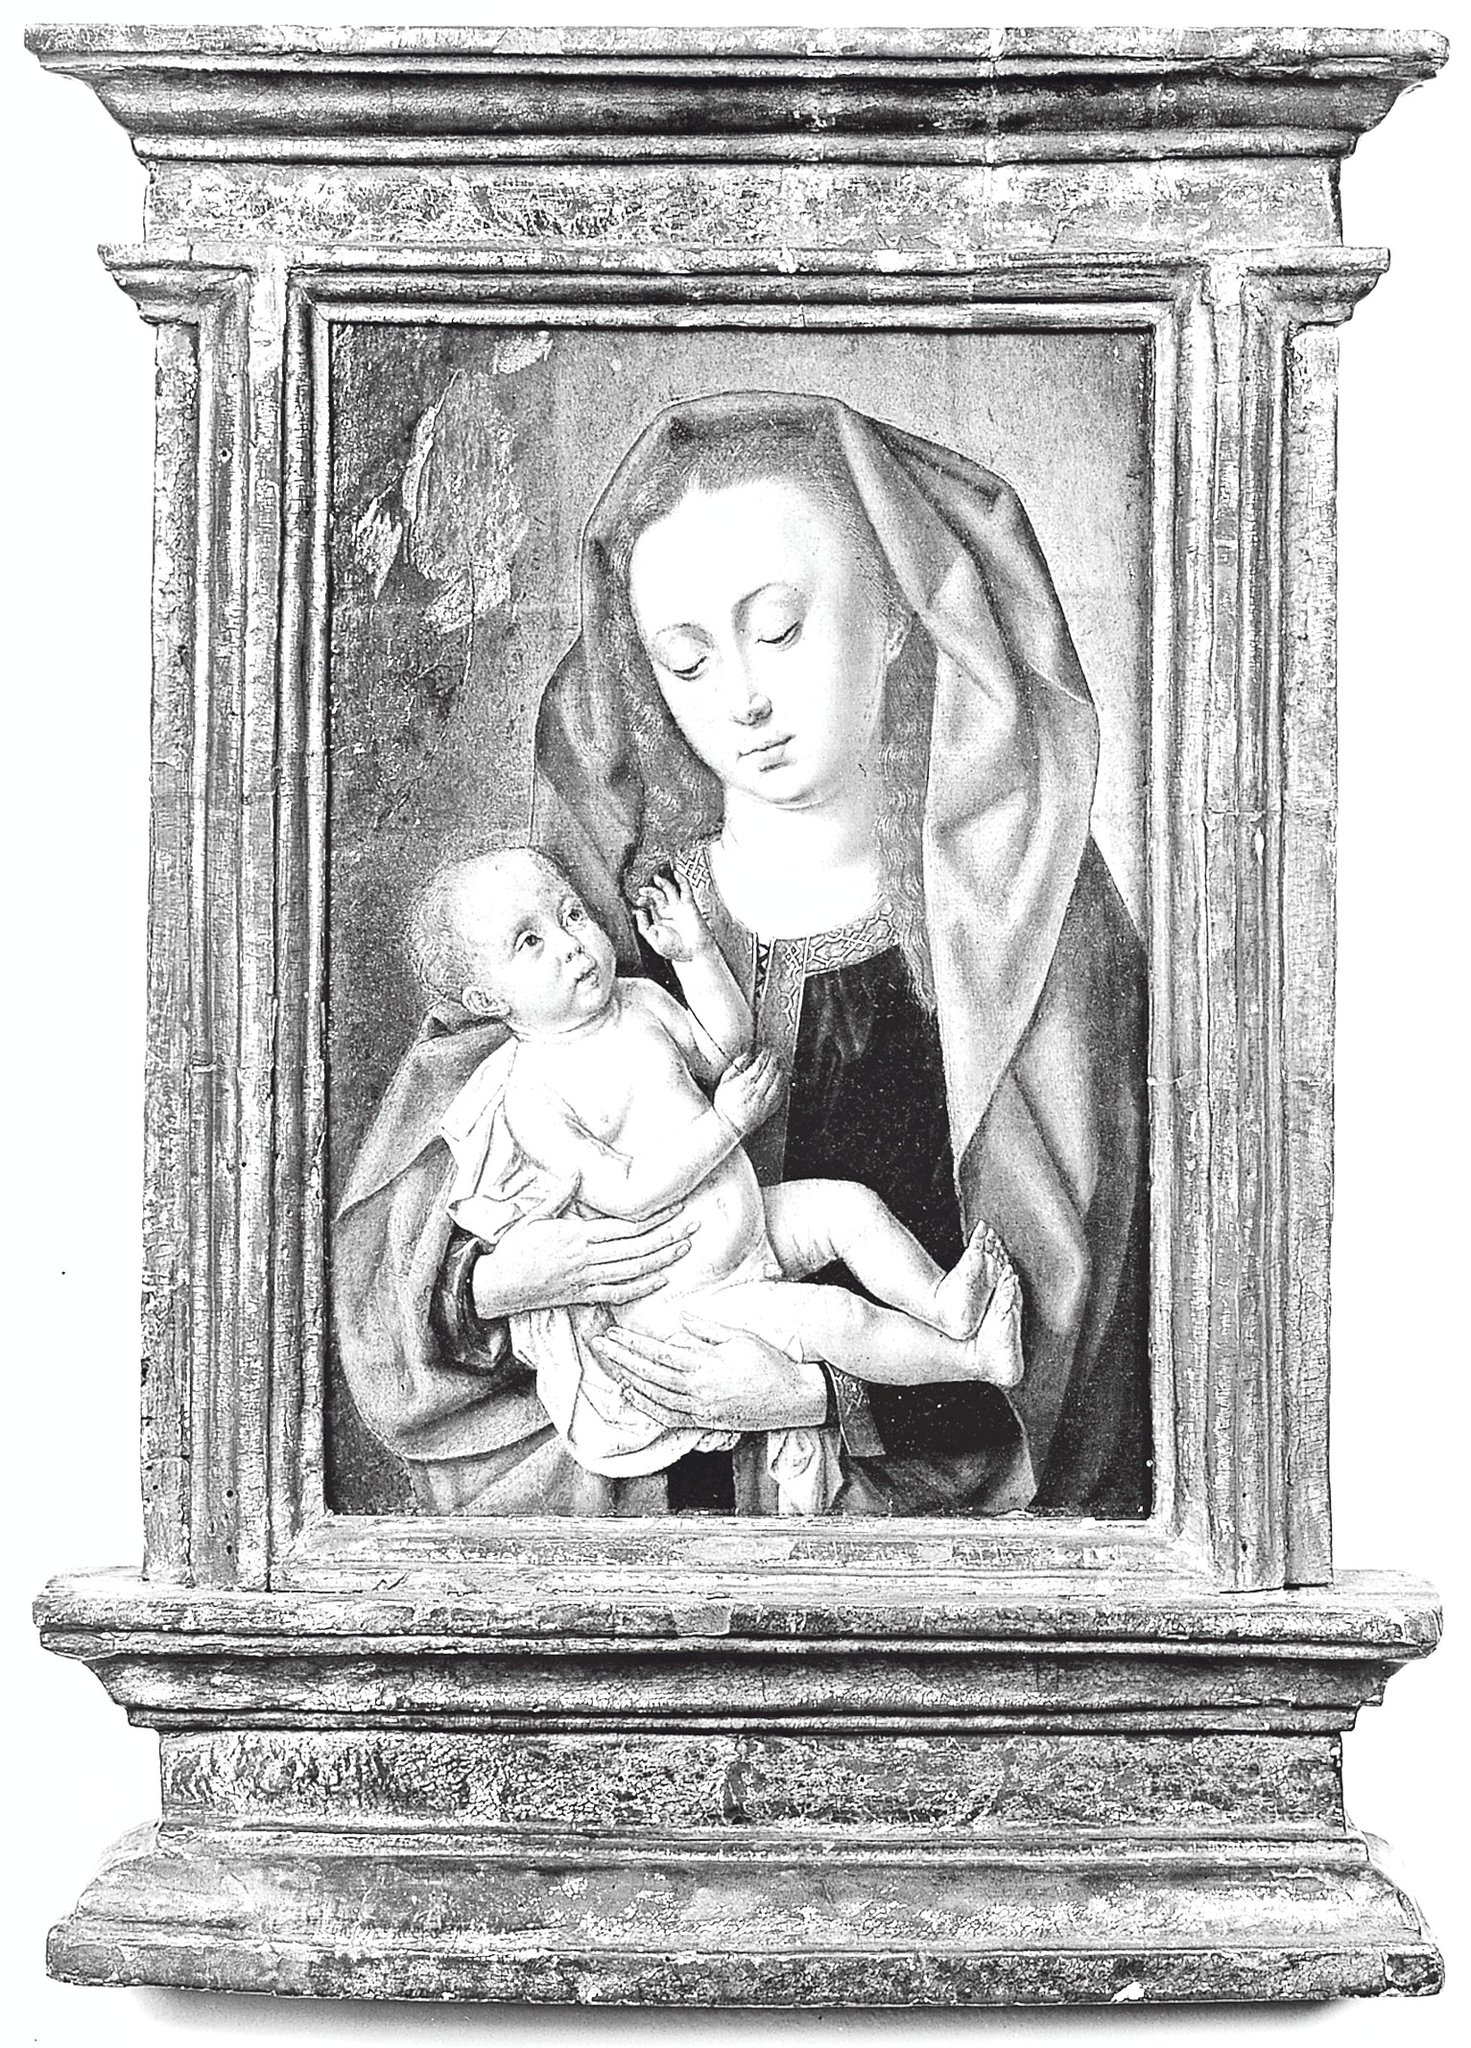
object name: frame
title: Tabernacle frame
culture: spanish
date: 1501-1600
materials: wood